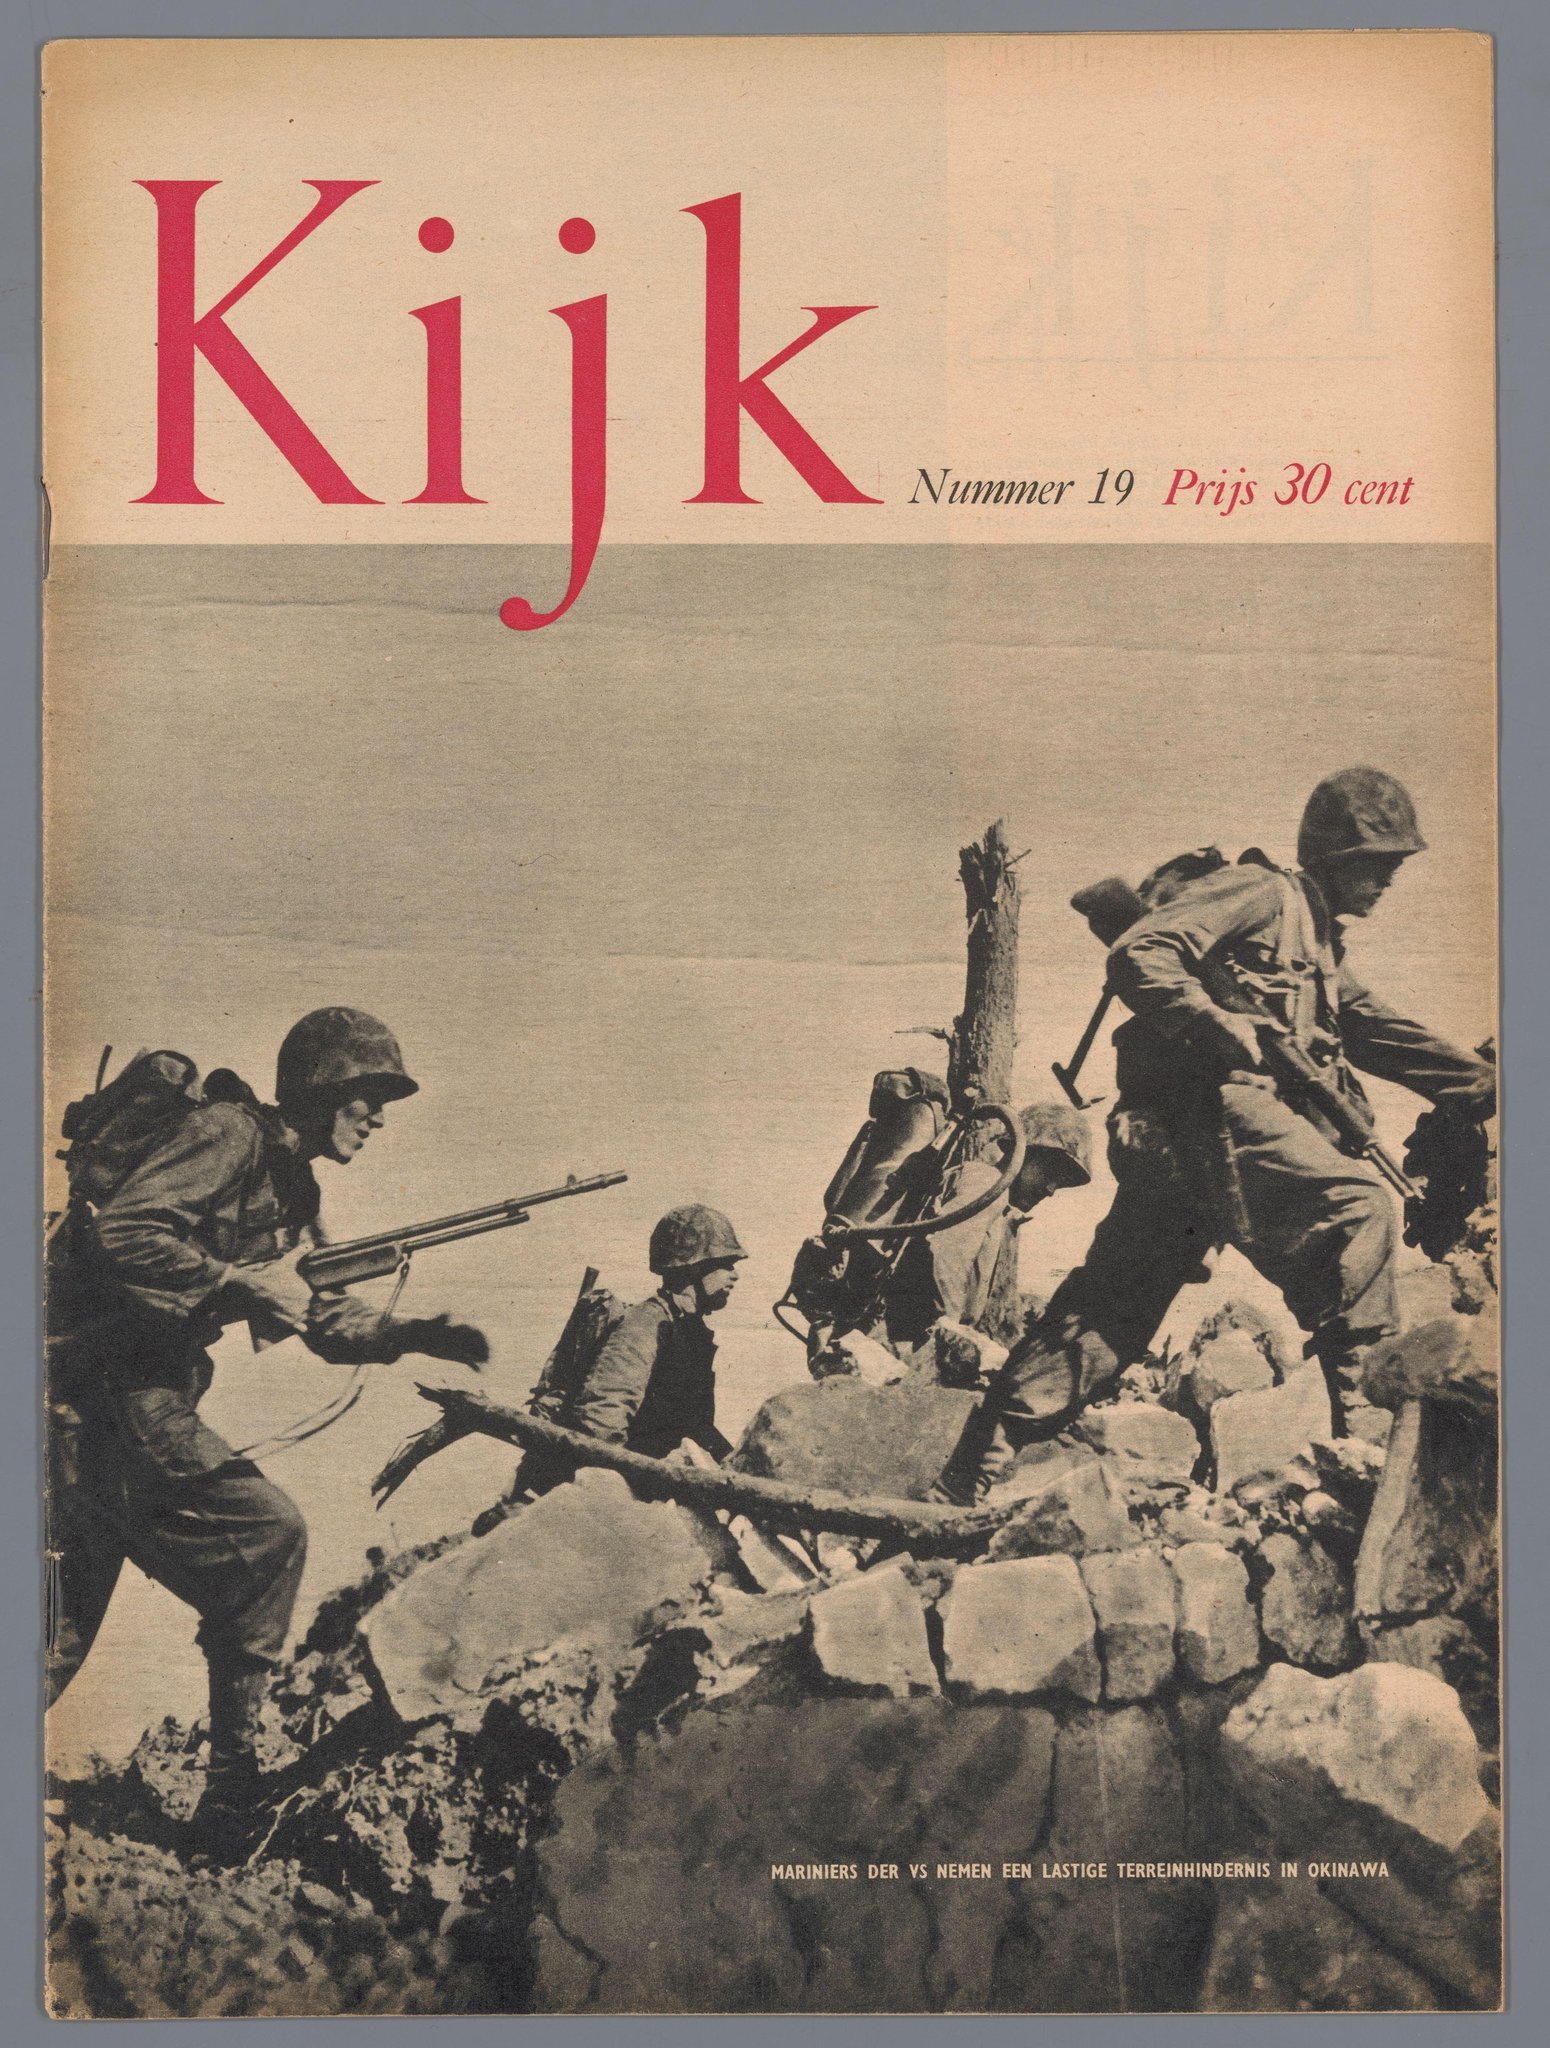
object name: magazine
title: 'Kijk', exemplaar nr. 19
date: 1945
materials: paper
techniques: printing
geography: london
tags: tweede wereldoorlog, bevrijding van nederland (1945)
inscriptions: title: ‘Kijk’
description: "Kijk wordt om de veertien dagen uitgegeven door de Amerikaanschen Voorlichingsdienst om eht wereldnieuws te geven in woord en beeld, totdat uw eigen pers deze taak kan overnemen." Omschrijving van het blad Kijk, overgenomen uit dit blad.